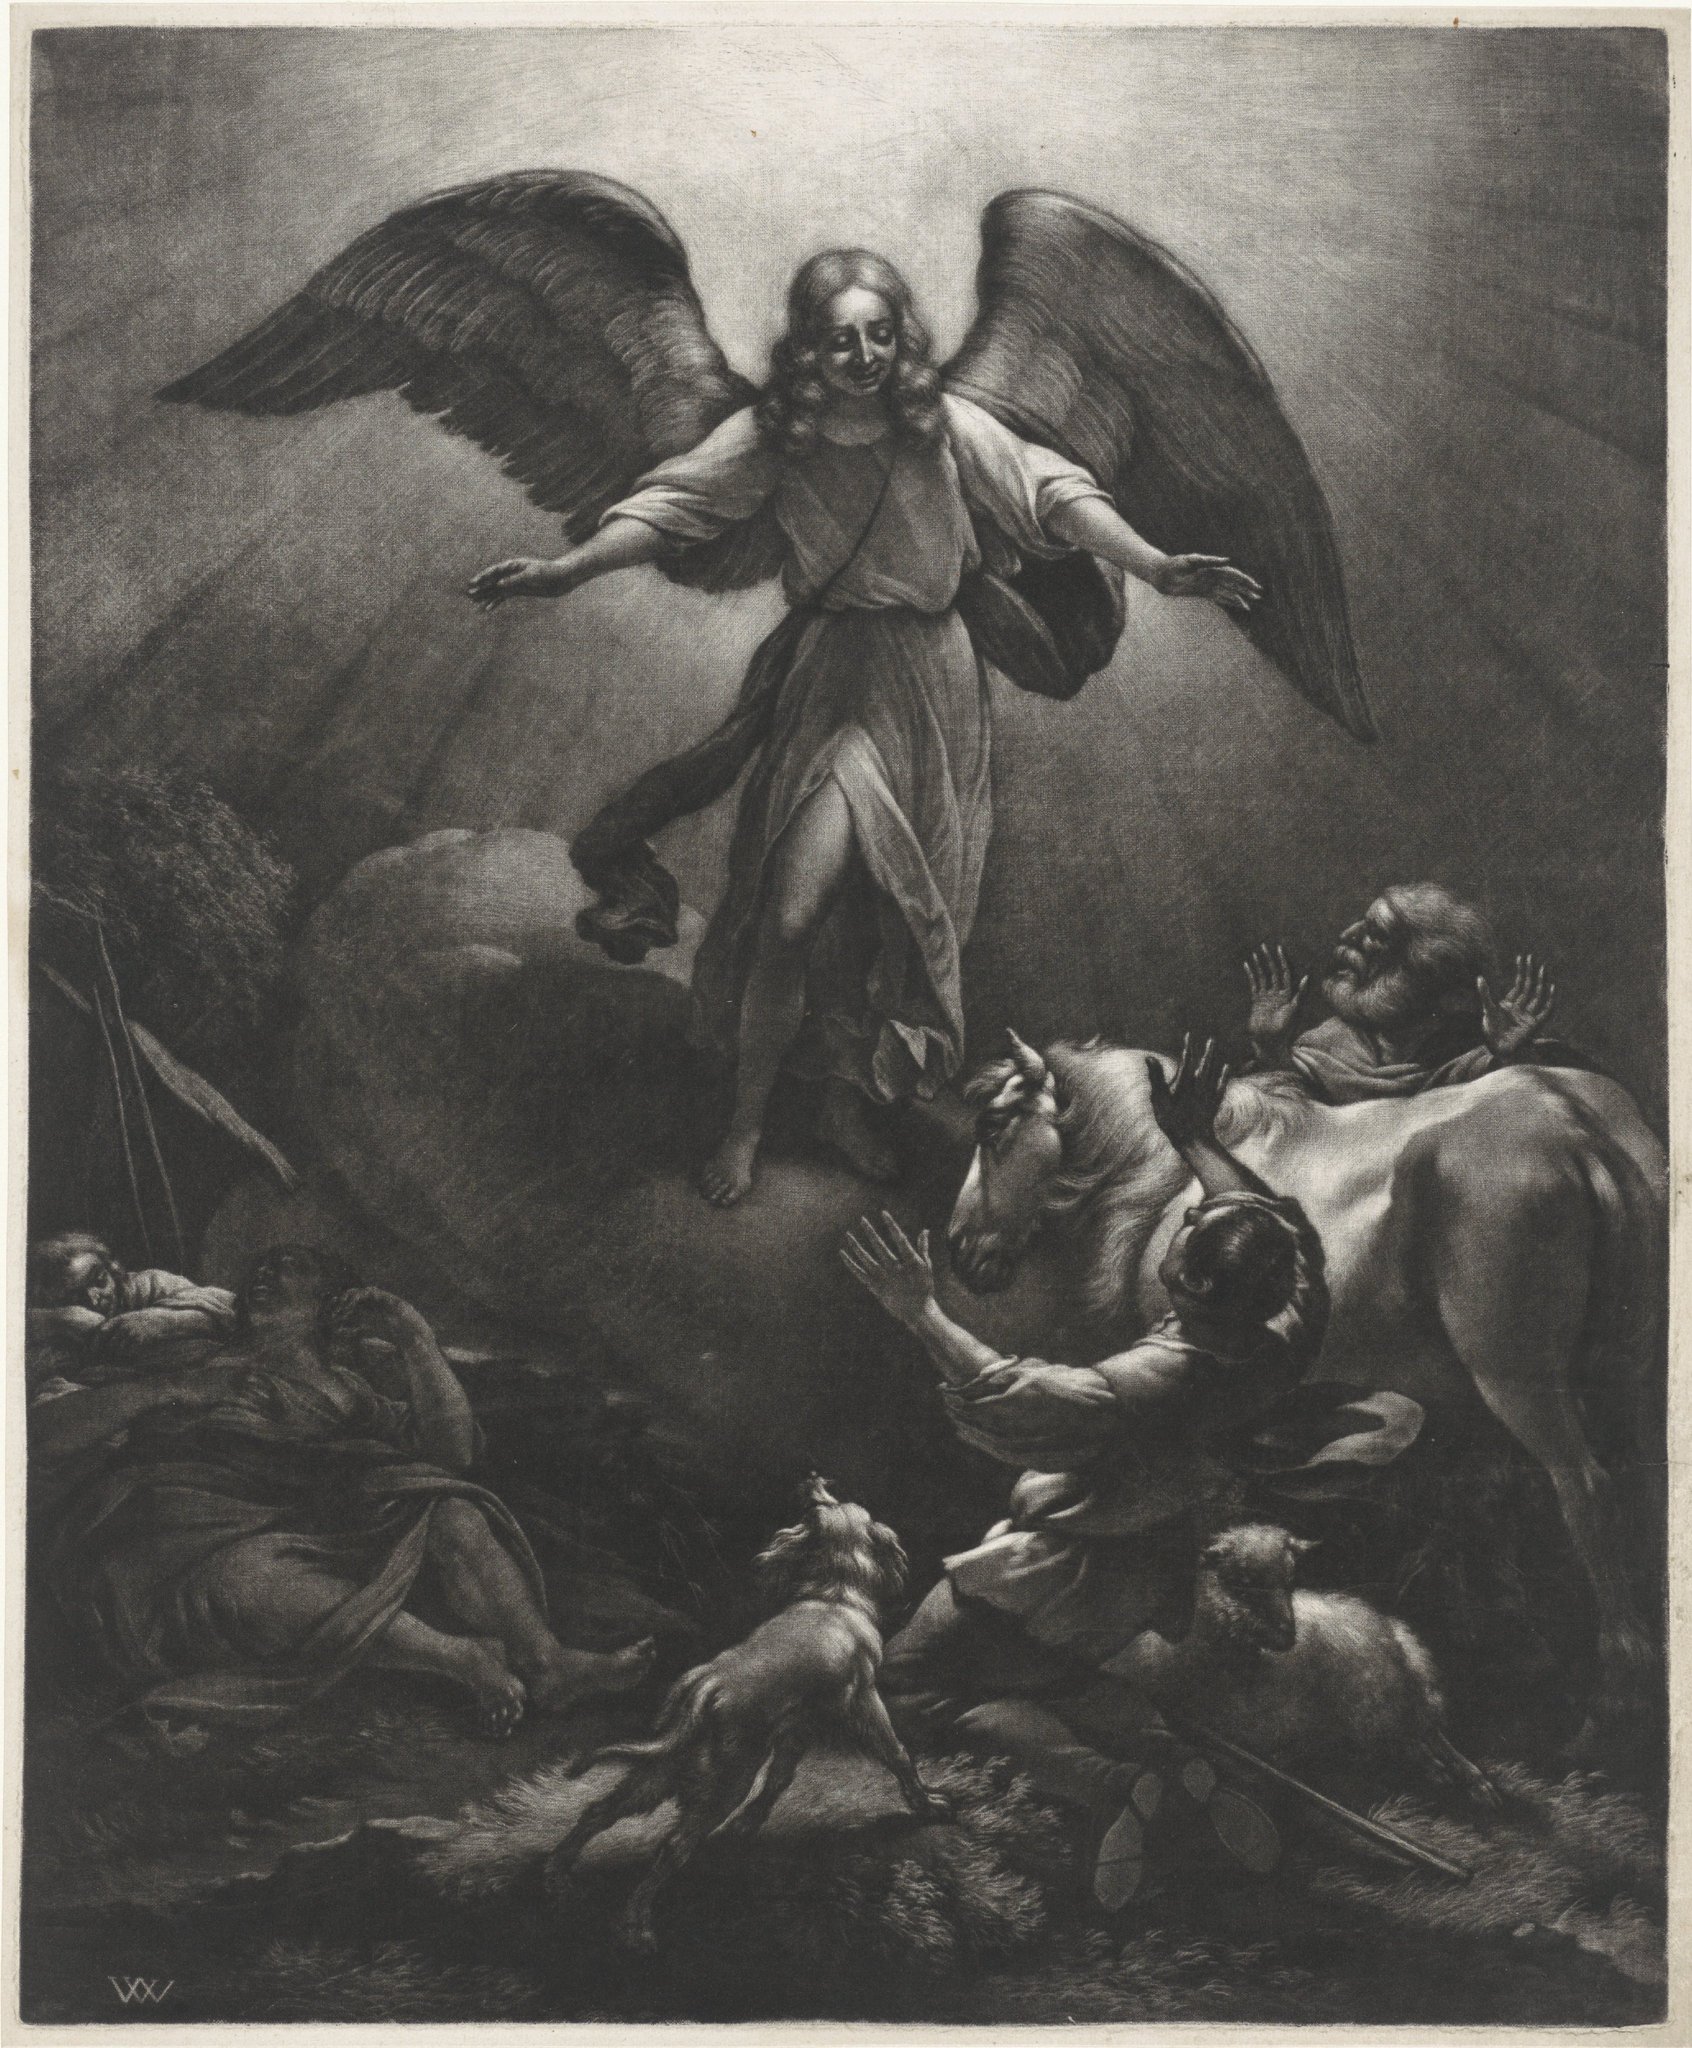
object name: print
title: Verkondiging aan de herders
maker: wallerant vaillant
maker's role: draughtsman, painter, print maker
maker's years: 1623-1677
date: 1658-1677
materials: paper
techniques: mezzotint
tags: annunciation of christ's birth to the shepherds (and/or shepherdesses) at night; a host of singing angels in the air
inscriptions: collector's mark: Lugt 2228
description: Een groep van herders en hun families wordt 's nachts gewekt door een engel die in de wolkenhemel verschijnt en de geboorte van Christus aankondigt.